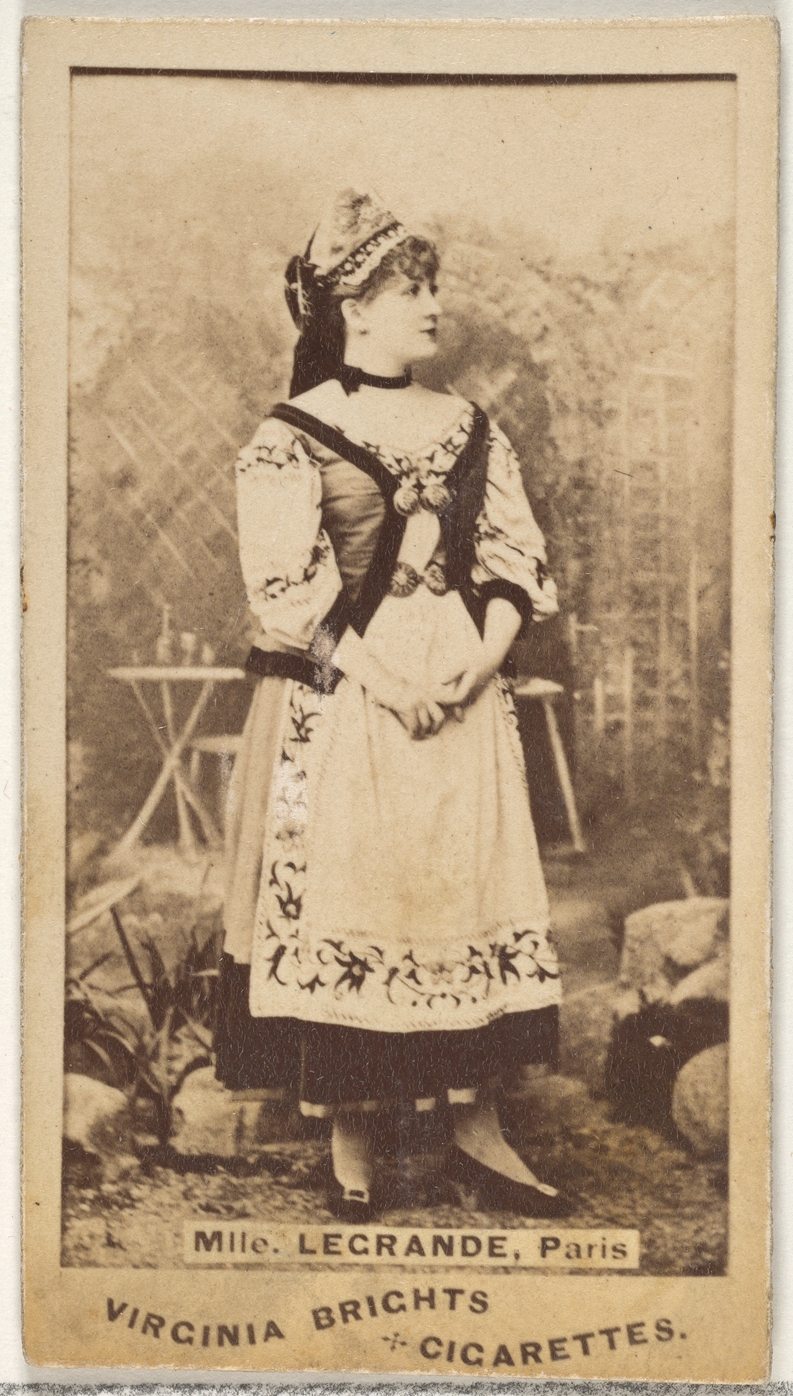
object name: photograph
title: Mlle. Legrande, Paris, from the Actors and Actresses series (N45, Type 1) for Virginia Brights Cigarettes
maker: allen & ginter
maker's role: publisher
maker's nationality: american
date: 1888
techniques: albumen silver print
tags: portraits,women,actresses